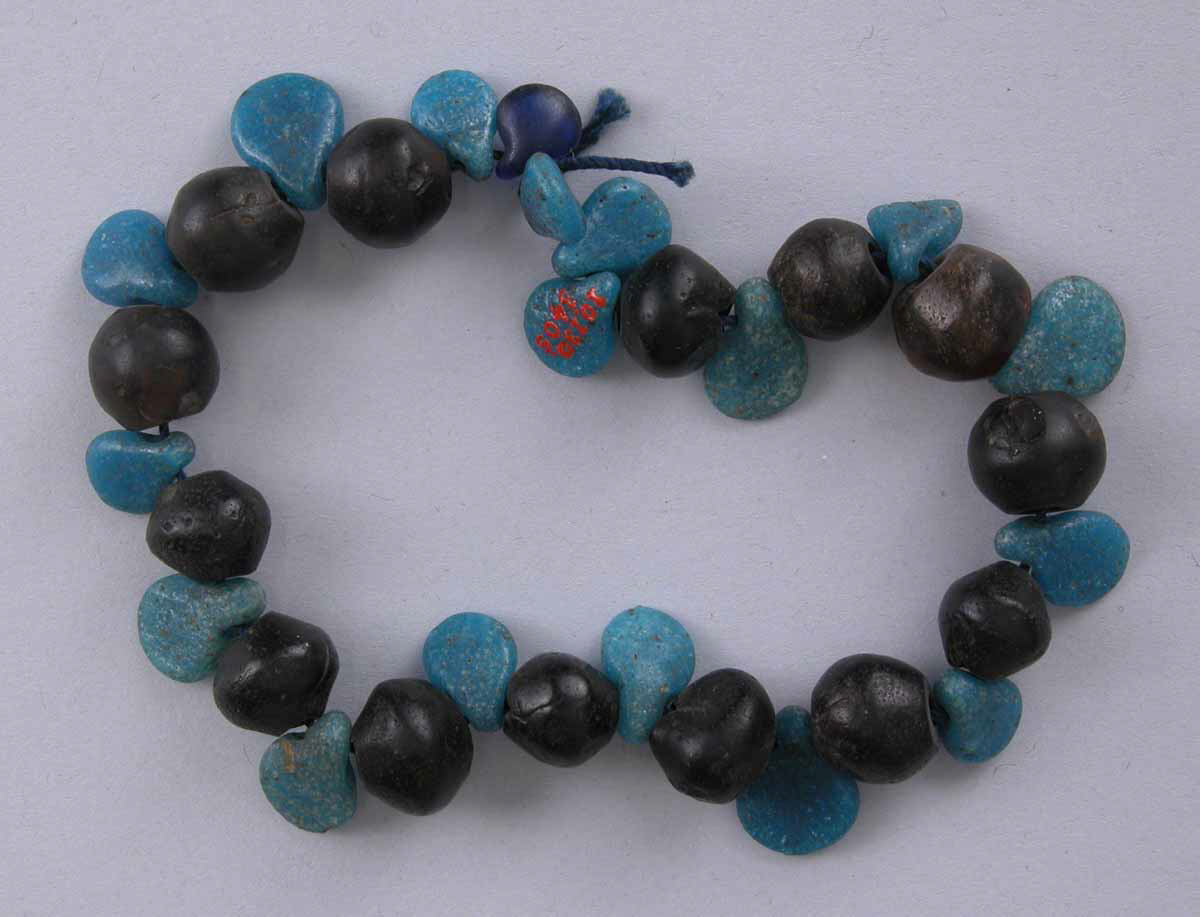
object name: bead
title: Beads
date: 801-1900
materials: glass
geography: egypt